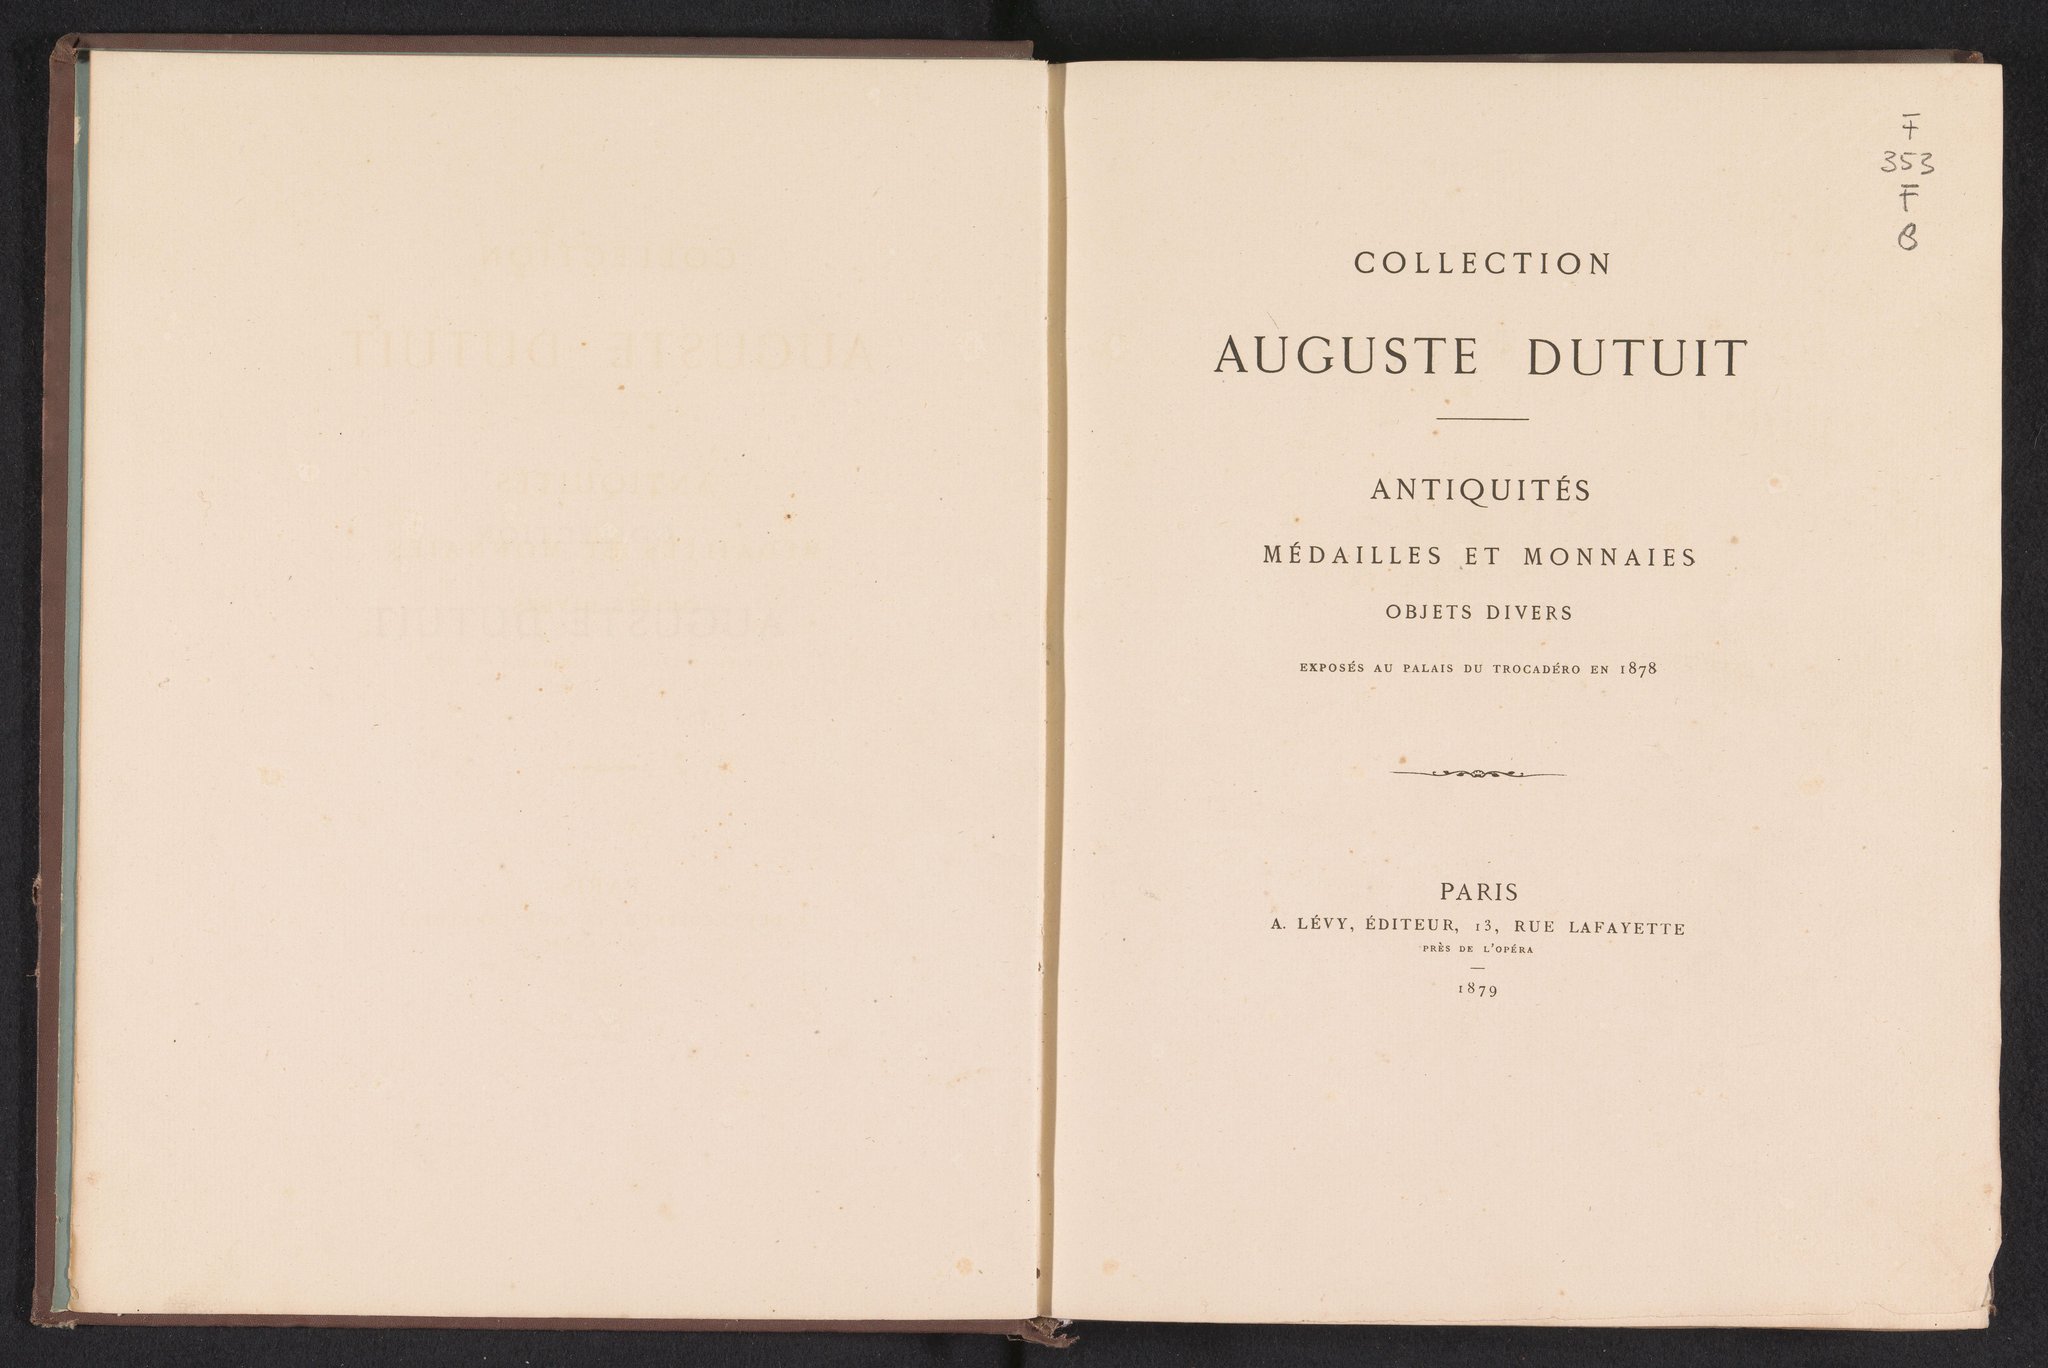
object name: book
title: Collection Auguste Dutuit antiquités médailles et monnaies, objets divers exposés au Palais du Trocadéro en 1878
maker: albert lévy (uitgever)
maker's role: publisher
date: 1879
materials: cardboard, linen, paper, photographic process, photographic support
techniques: albumen print, photograph, engraving, etching, lithograph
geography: paris